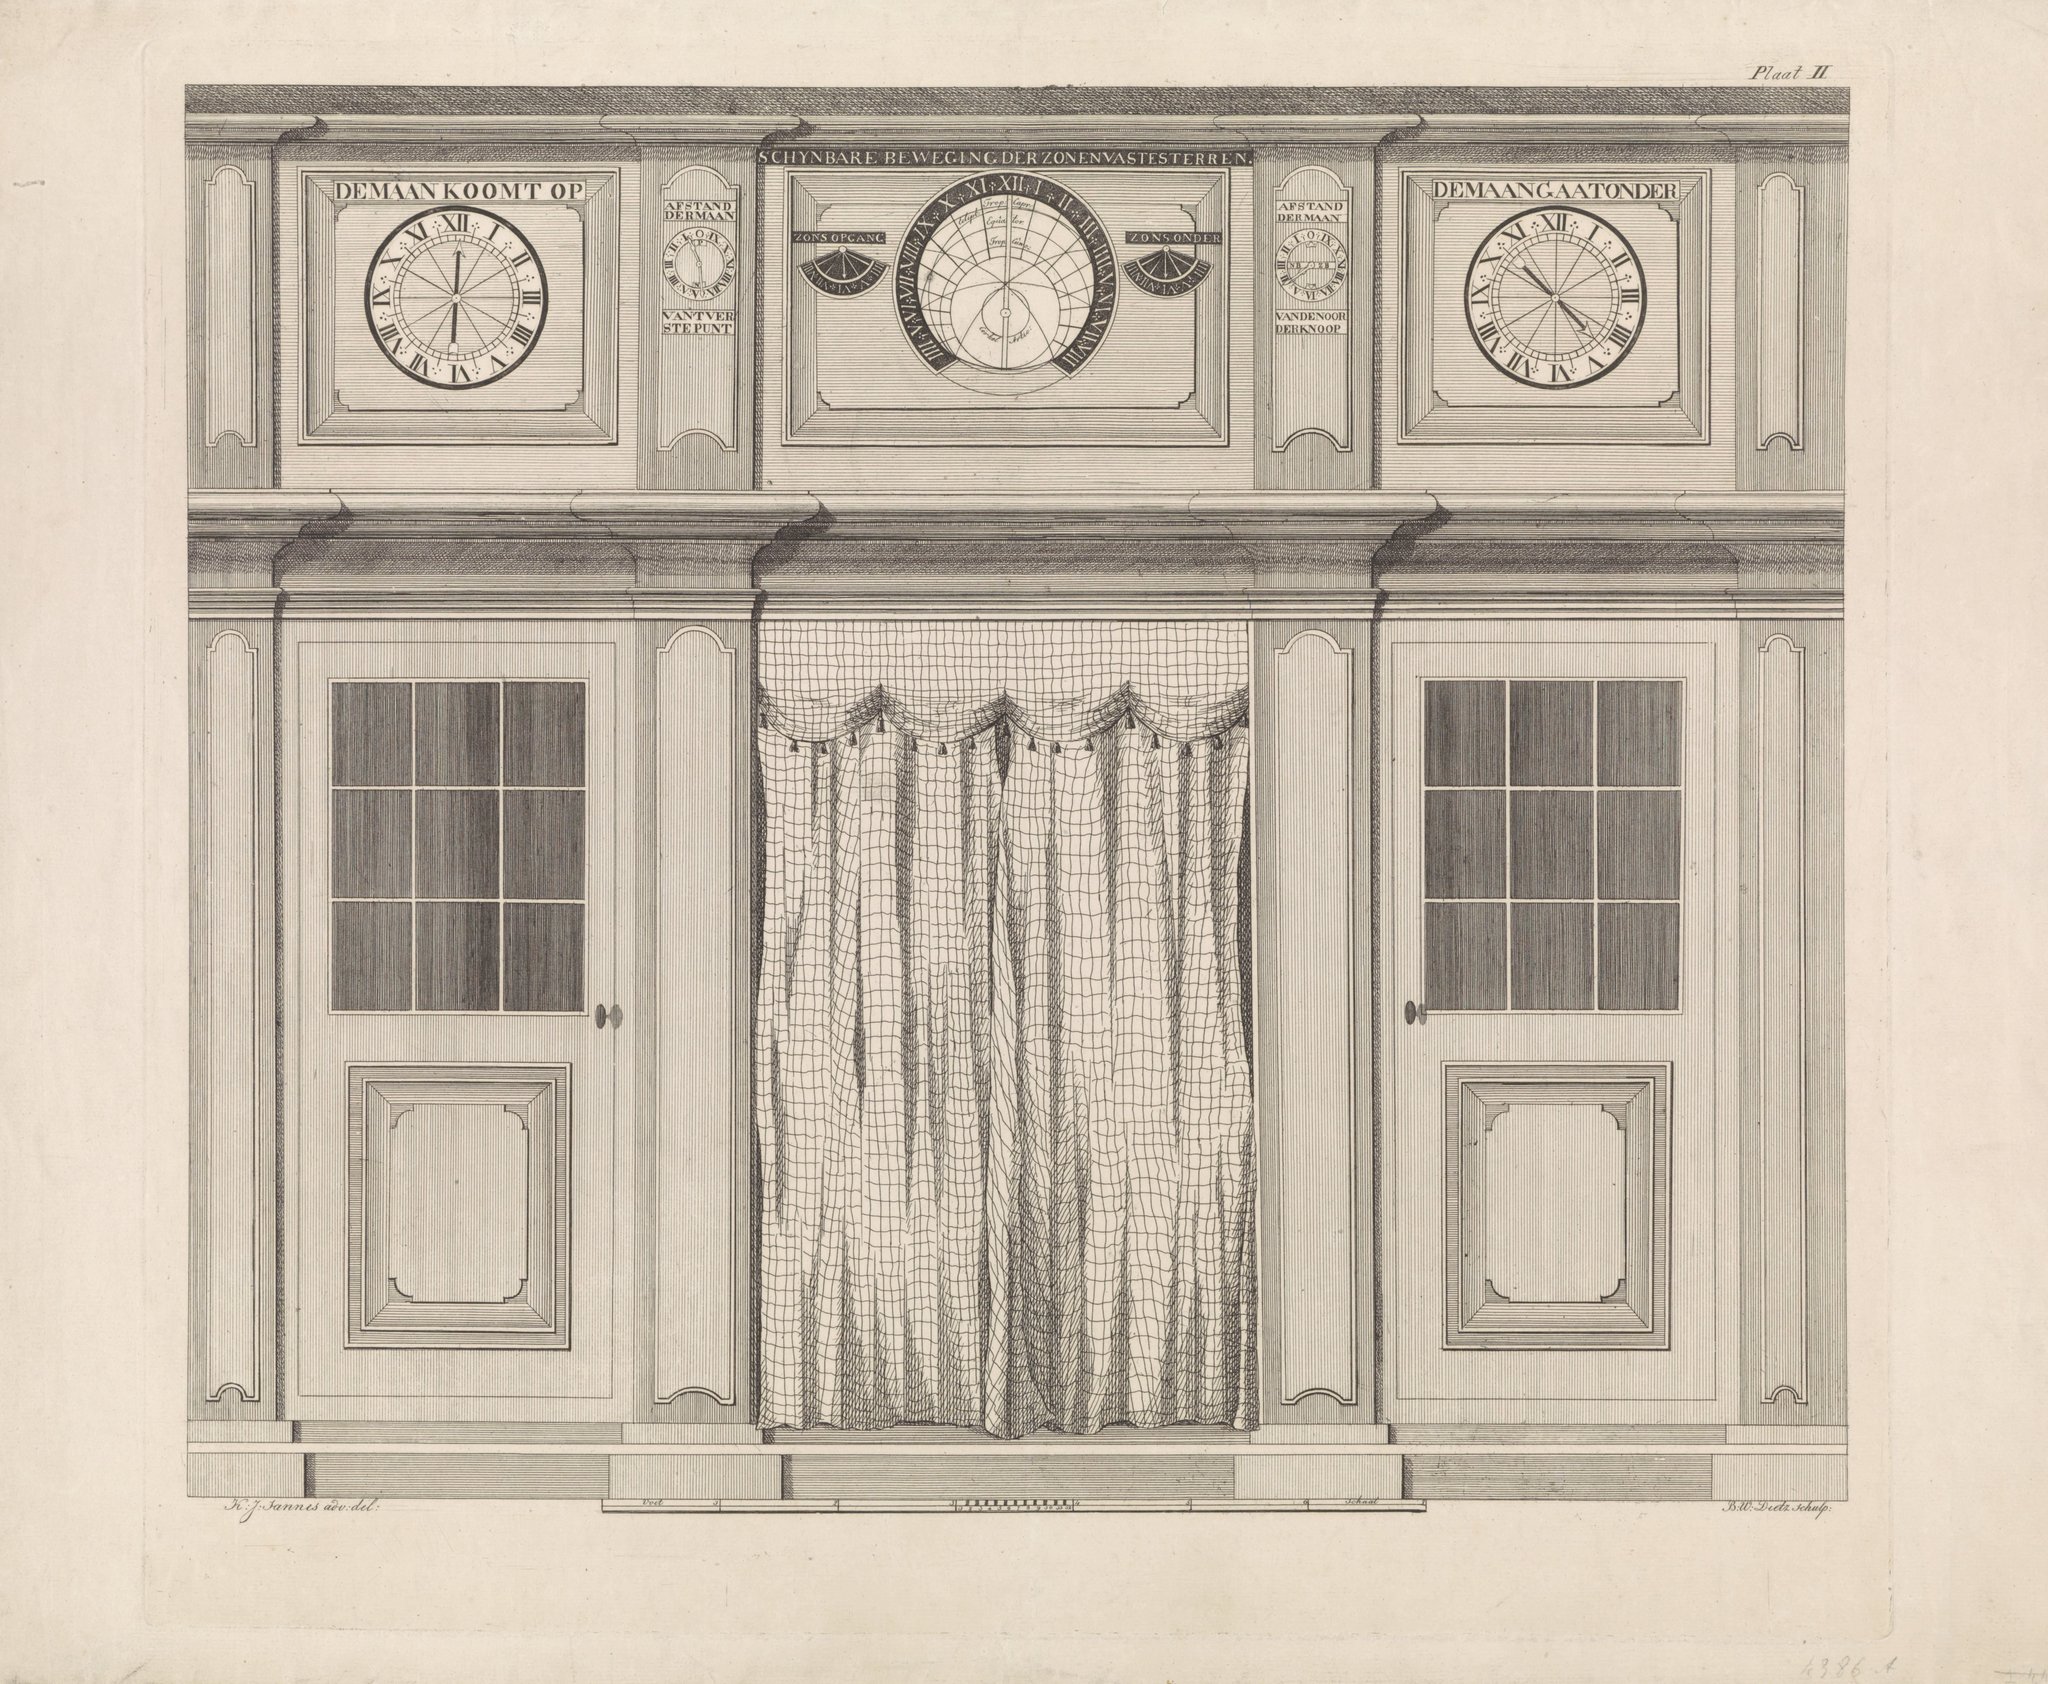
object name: print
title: Wandopstand van beweegbare planetarium van Eise Eisinga te Franeker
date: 1824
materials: paper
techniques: etching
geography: arnhem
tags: astronomical instruments, orrery, planetarium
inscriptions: collector's mark: Lugt 2228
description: Wandopstand in het interieur van het beweegbare planetarium van Eise Eisinga te Franeker. Met tijd aanduiding wanneer de maan opkomt en onder gaat en instrument voor weergave van de schijnbare beweging van de zon en vaste sterren.